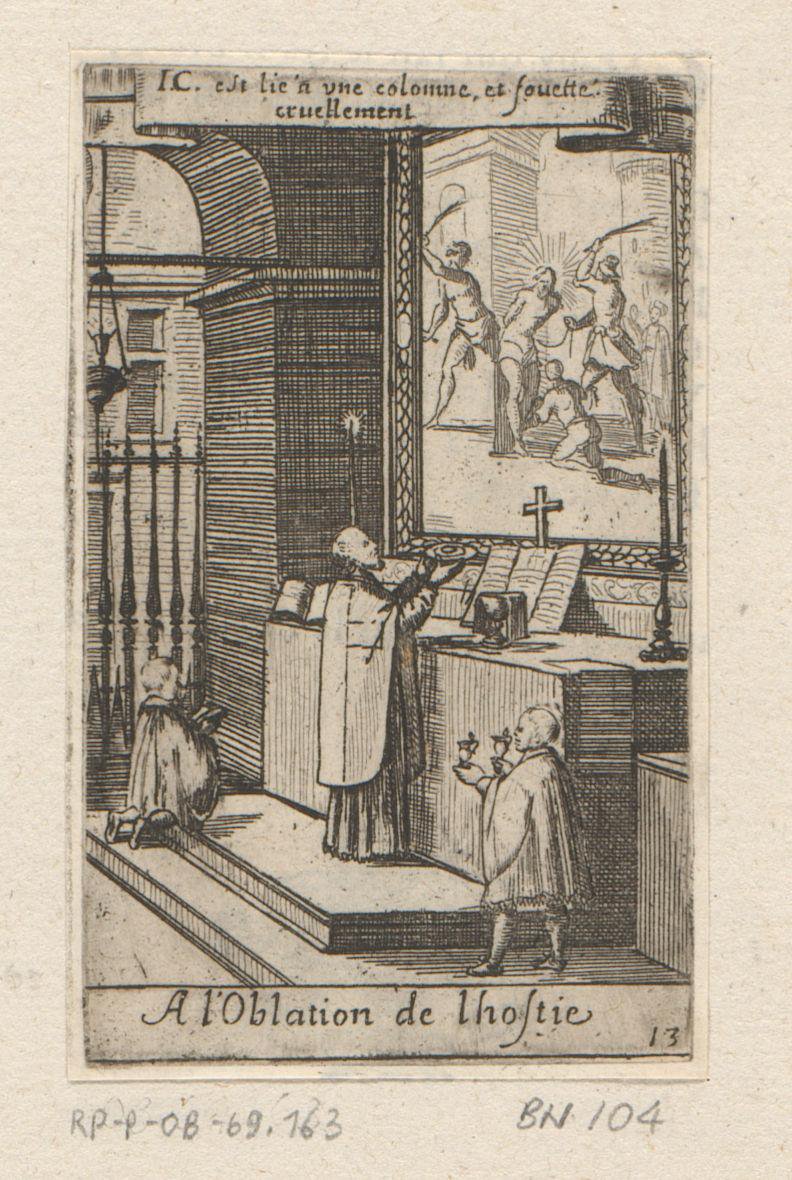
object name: print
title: Priester met hostie en twee misdienaars voor een altaar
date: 1661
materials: paper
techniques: etching, letterpress printing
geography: france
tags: priest (roman catholic), altar with altar-piece, communion ~ holy mass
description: Prent uit: Mengin, L. Tableaux ou sont representees la passion de N.S. Christ et les actions du prestre a la S. Messe (...). Metz: Claude Bouchard, 1661.